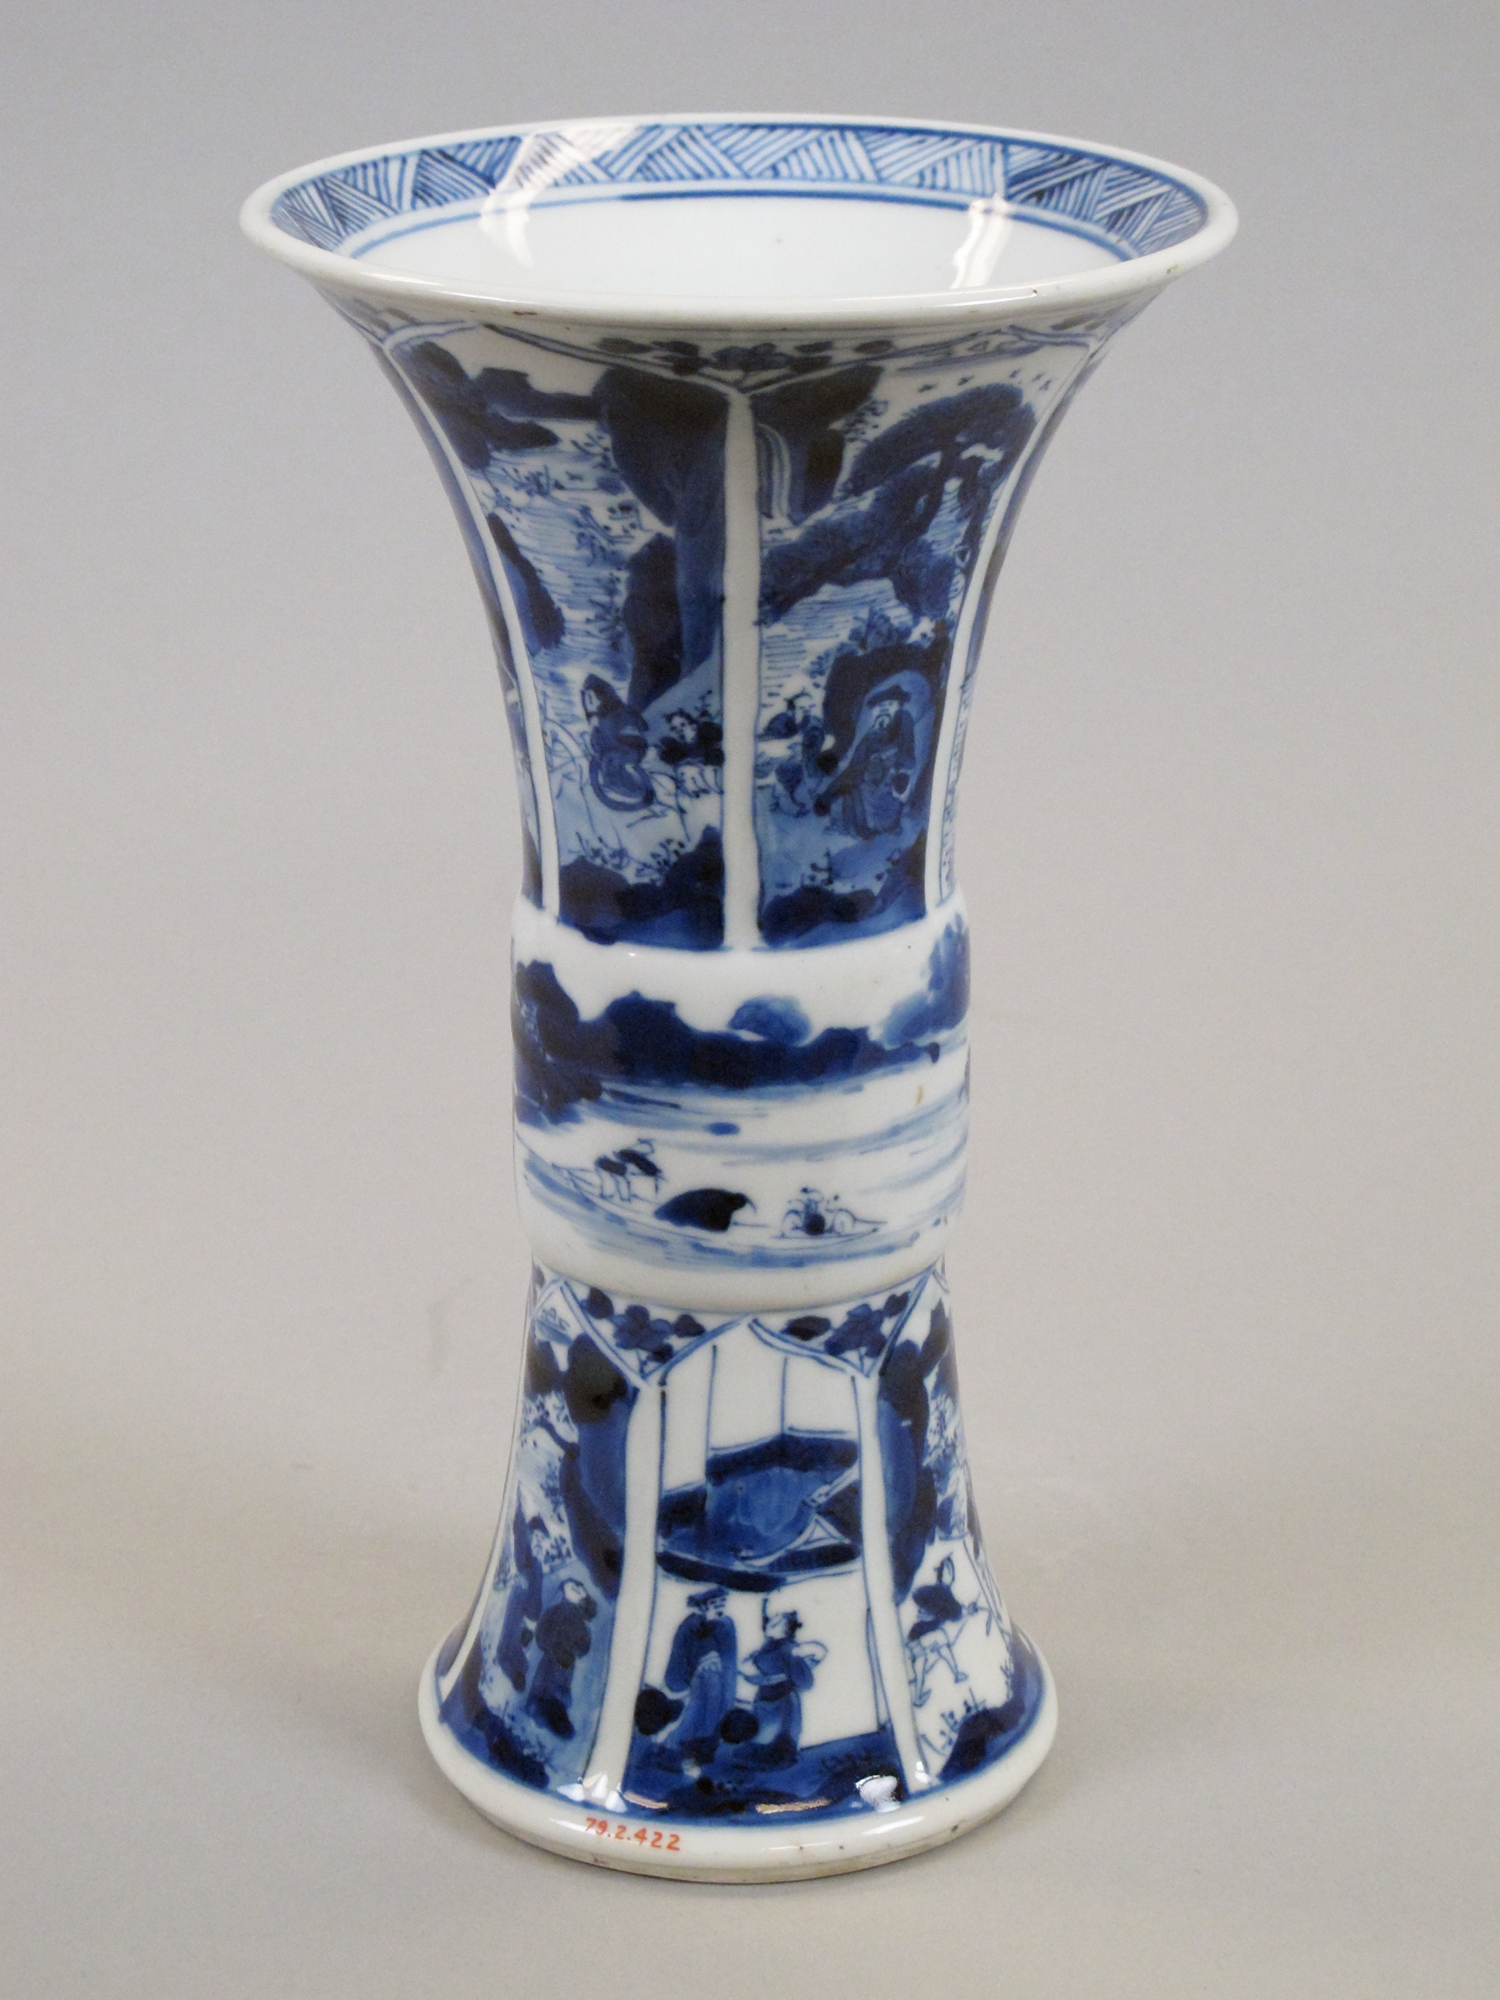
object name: vase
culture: chinese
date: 1667-1733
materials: porcelain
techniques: painting, underglaze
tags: human figures,trees